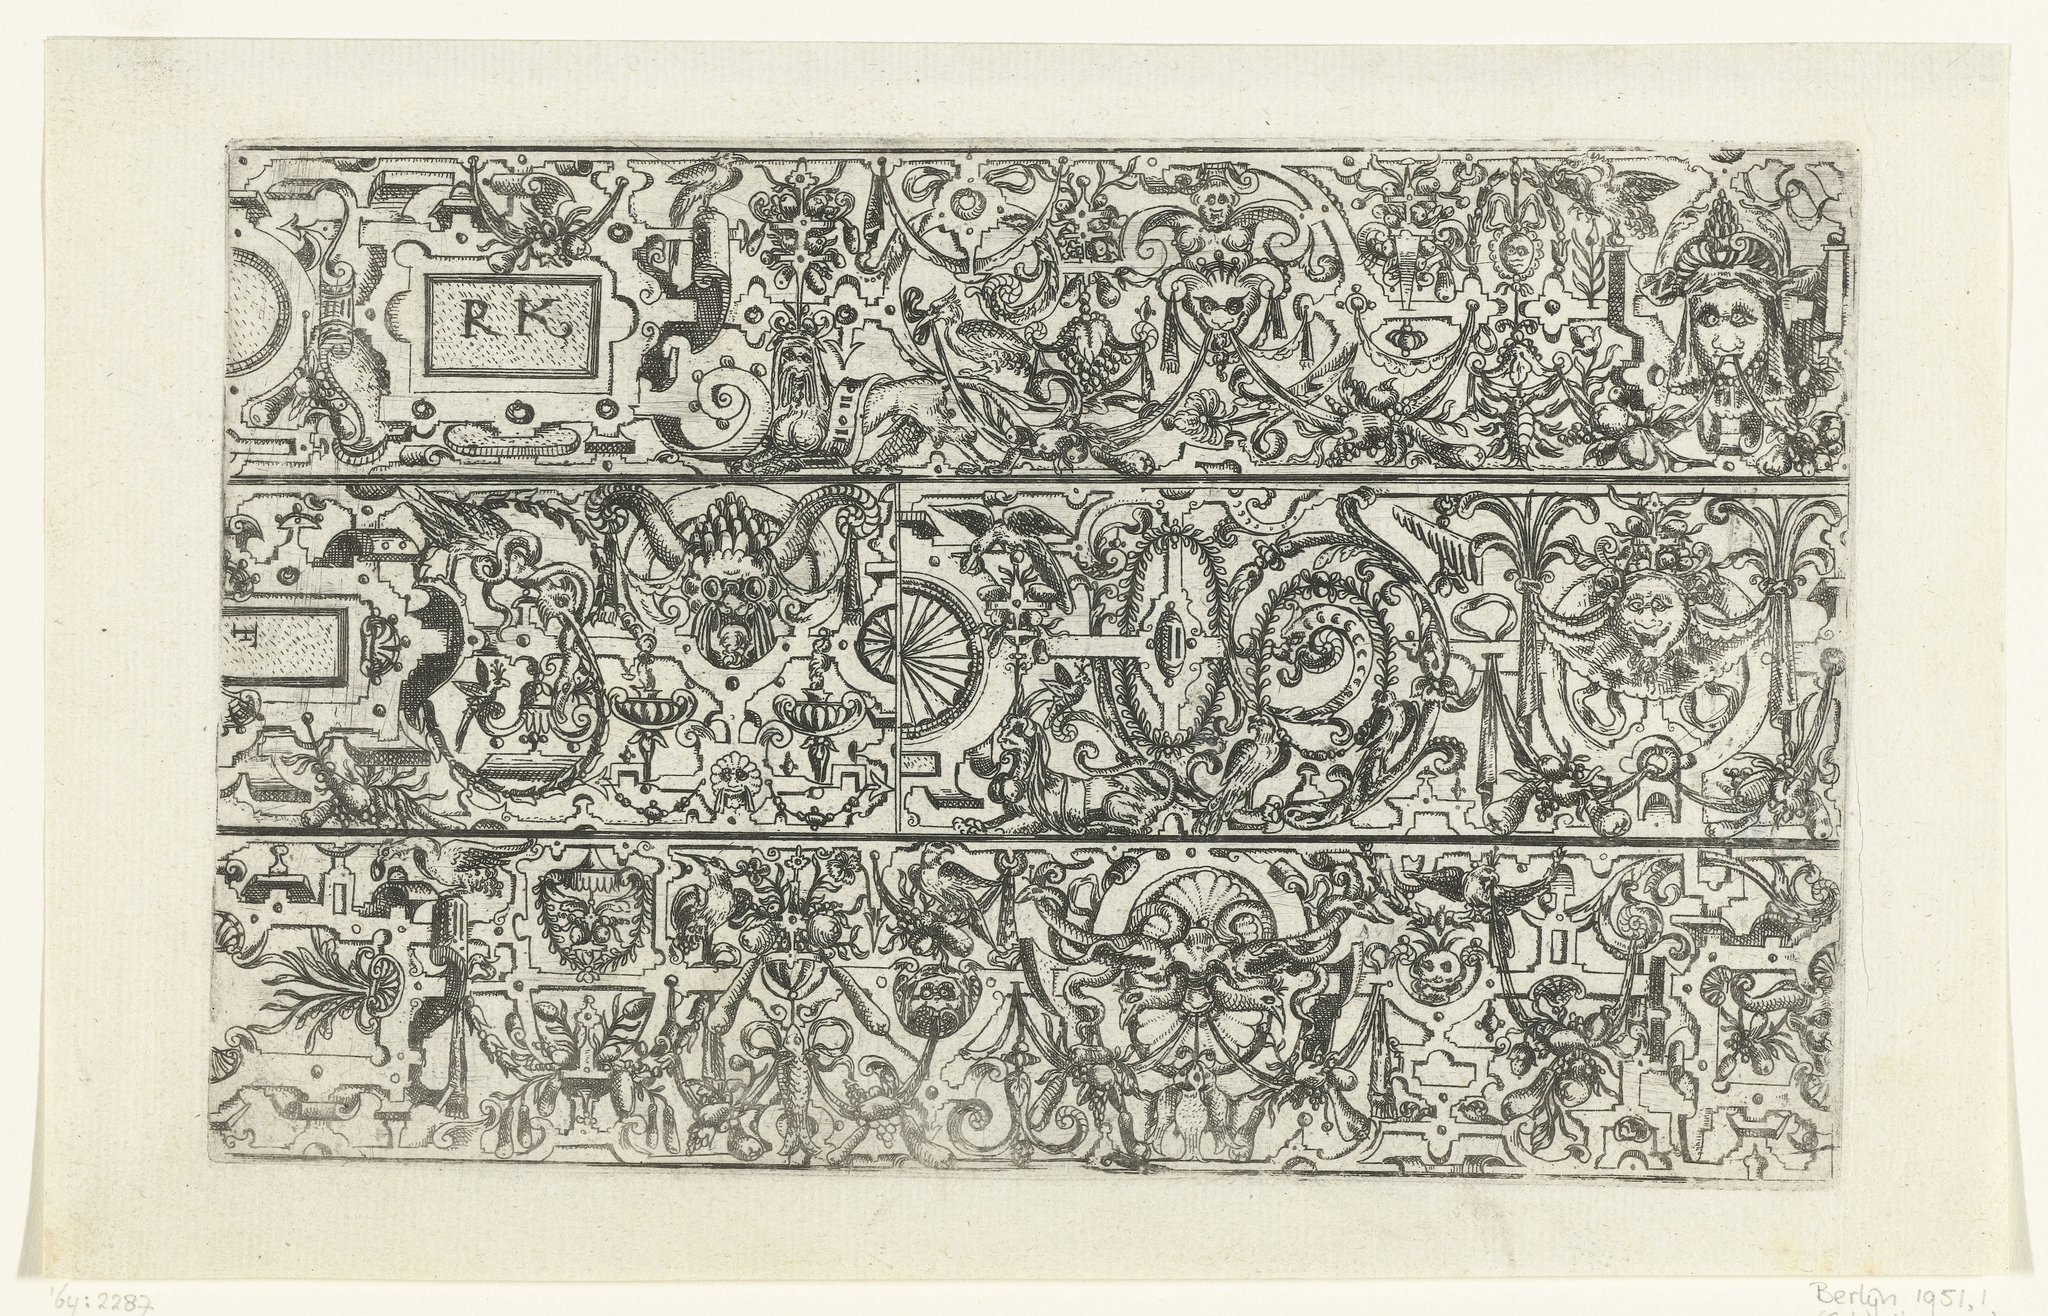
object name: print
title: Drie friezen met rolwerk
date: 1622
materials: paper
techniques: etching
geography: germany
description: Friezen, het middelste met een variant voor de rechterhelft, met rolwerk waarin grotesken, maskers en dieren zijn opgenomen. Blad F uit tweede editie van serie, bestaande uit 24 bladen.